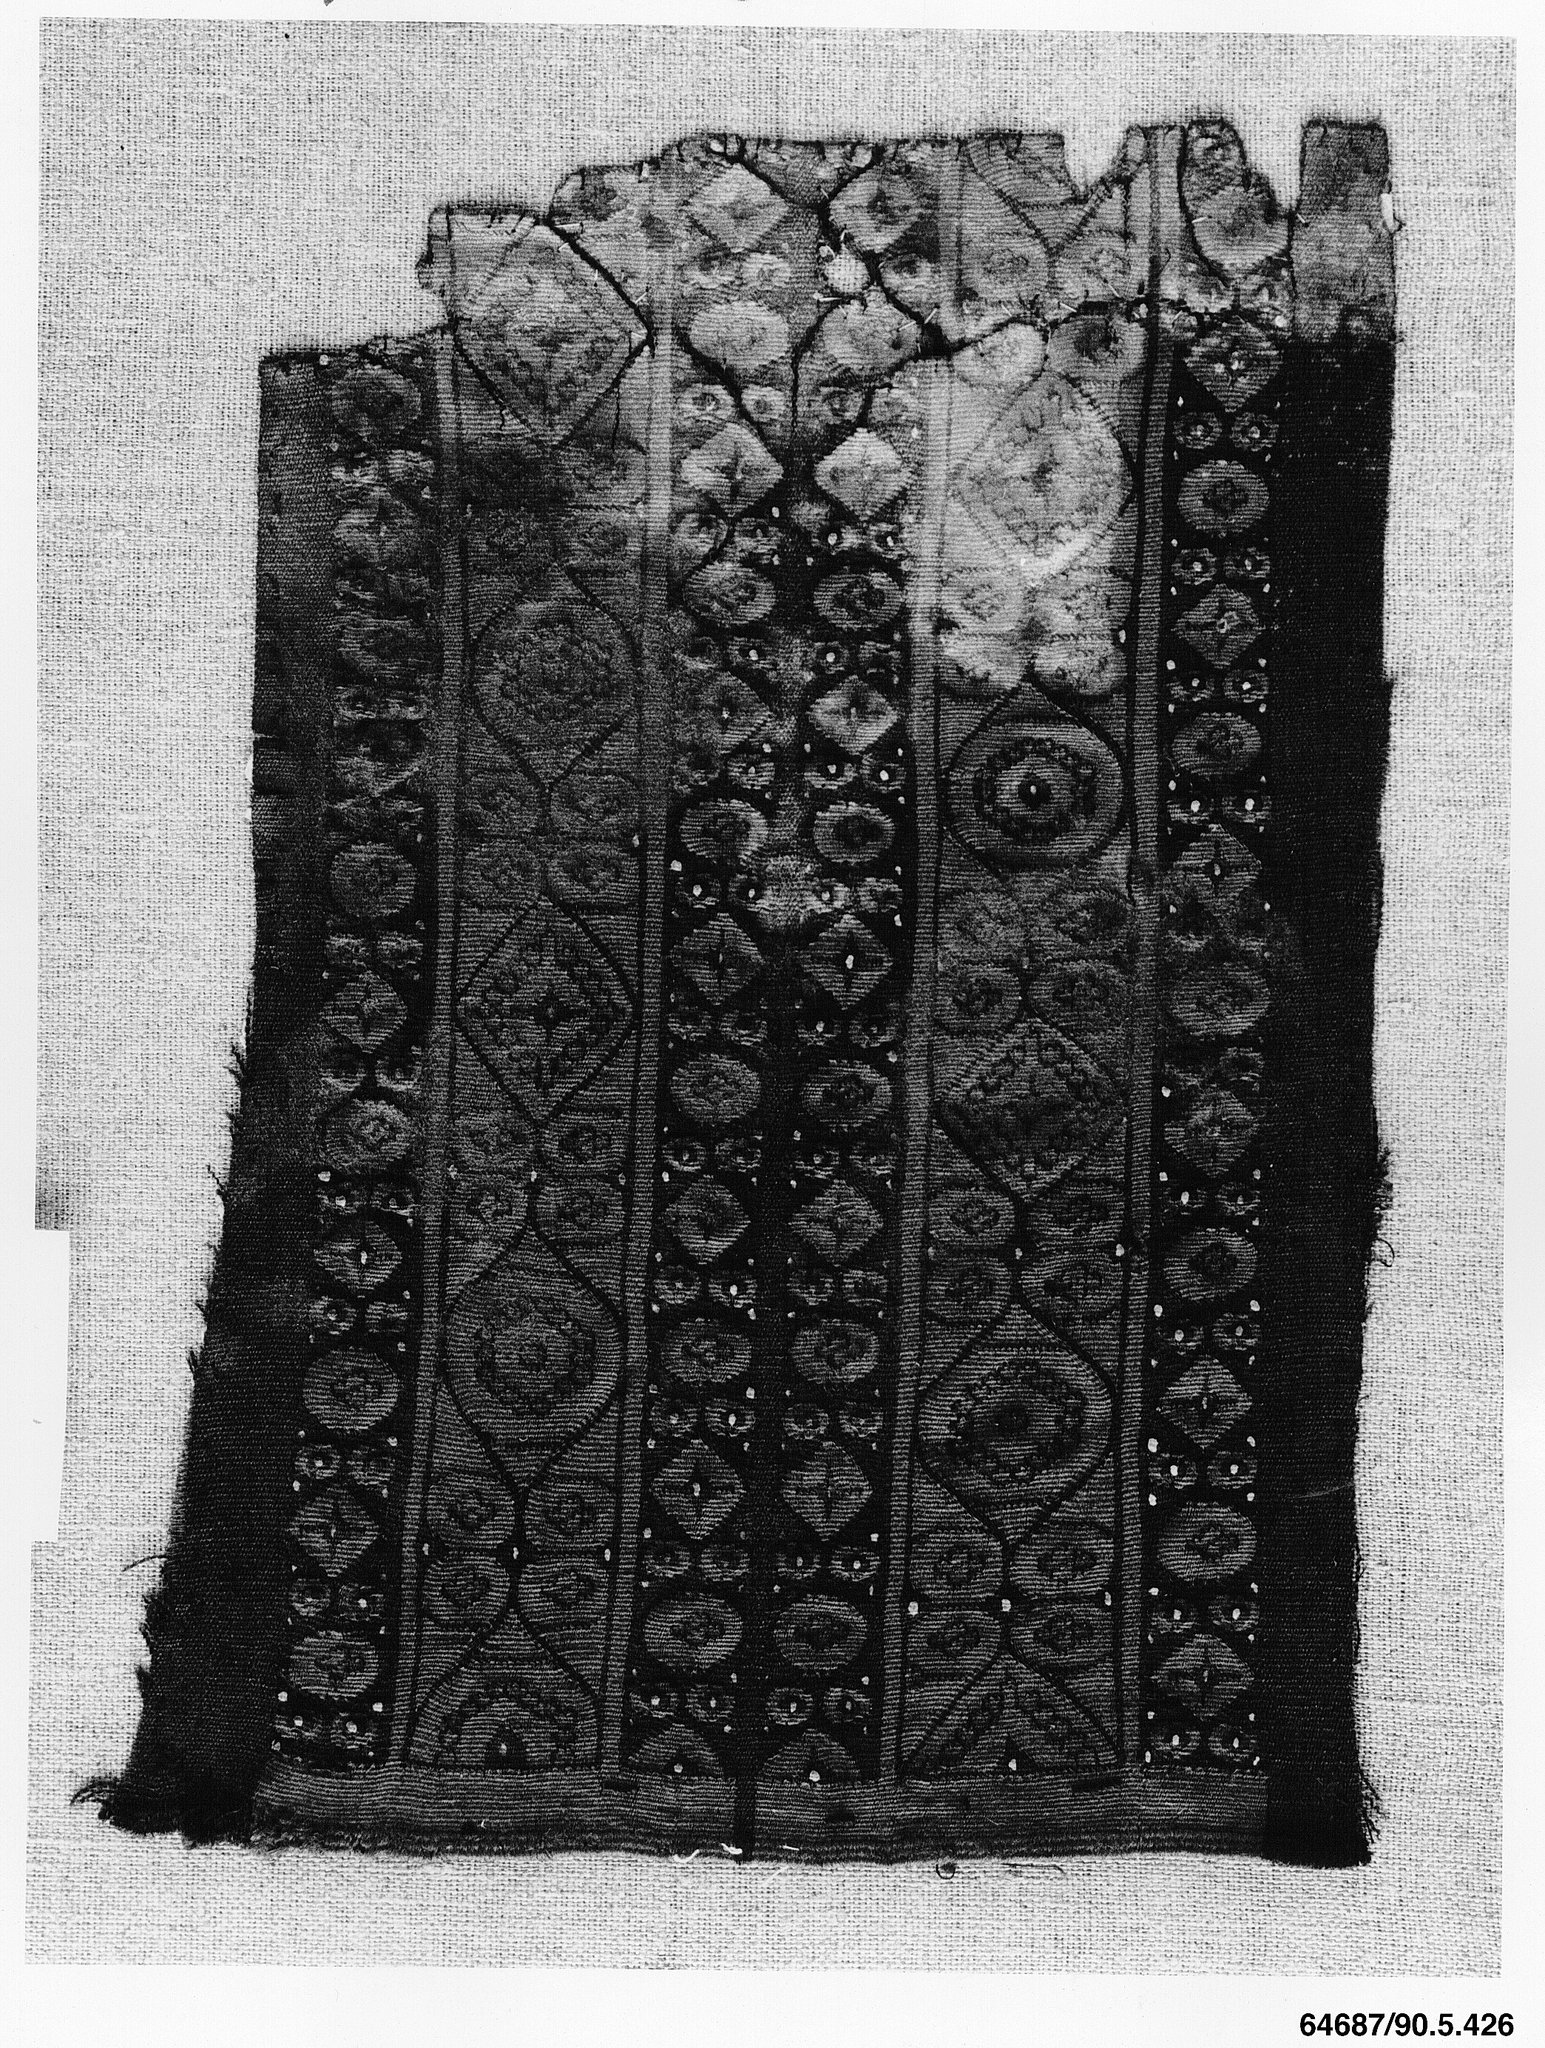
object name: textile fragment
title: Fragment of a Sleeve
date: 201-400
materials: linen, wool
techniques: weave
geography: egypt